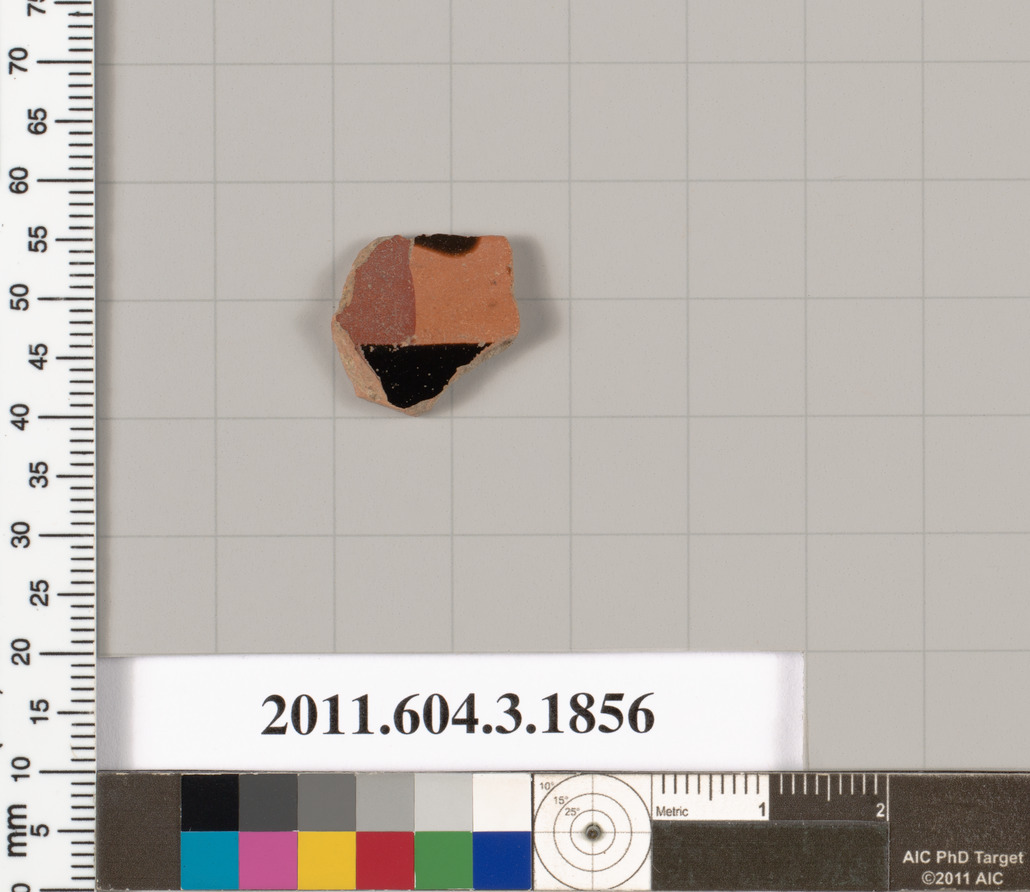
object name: kylix fragment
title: Terracotta fragment of a kylix: Lip cup (drinking cup)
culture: greek, attic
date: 550-526 BCE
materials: terracotta